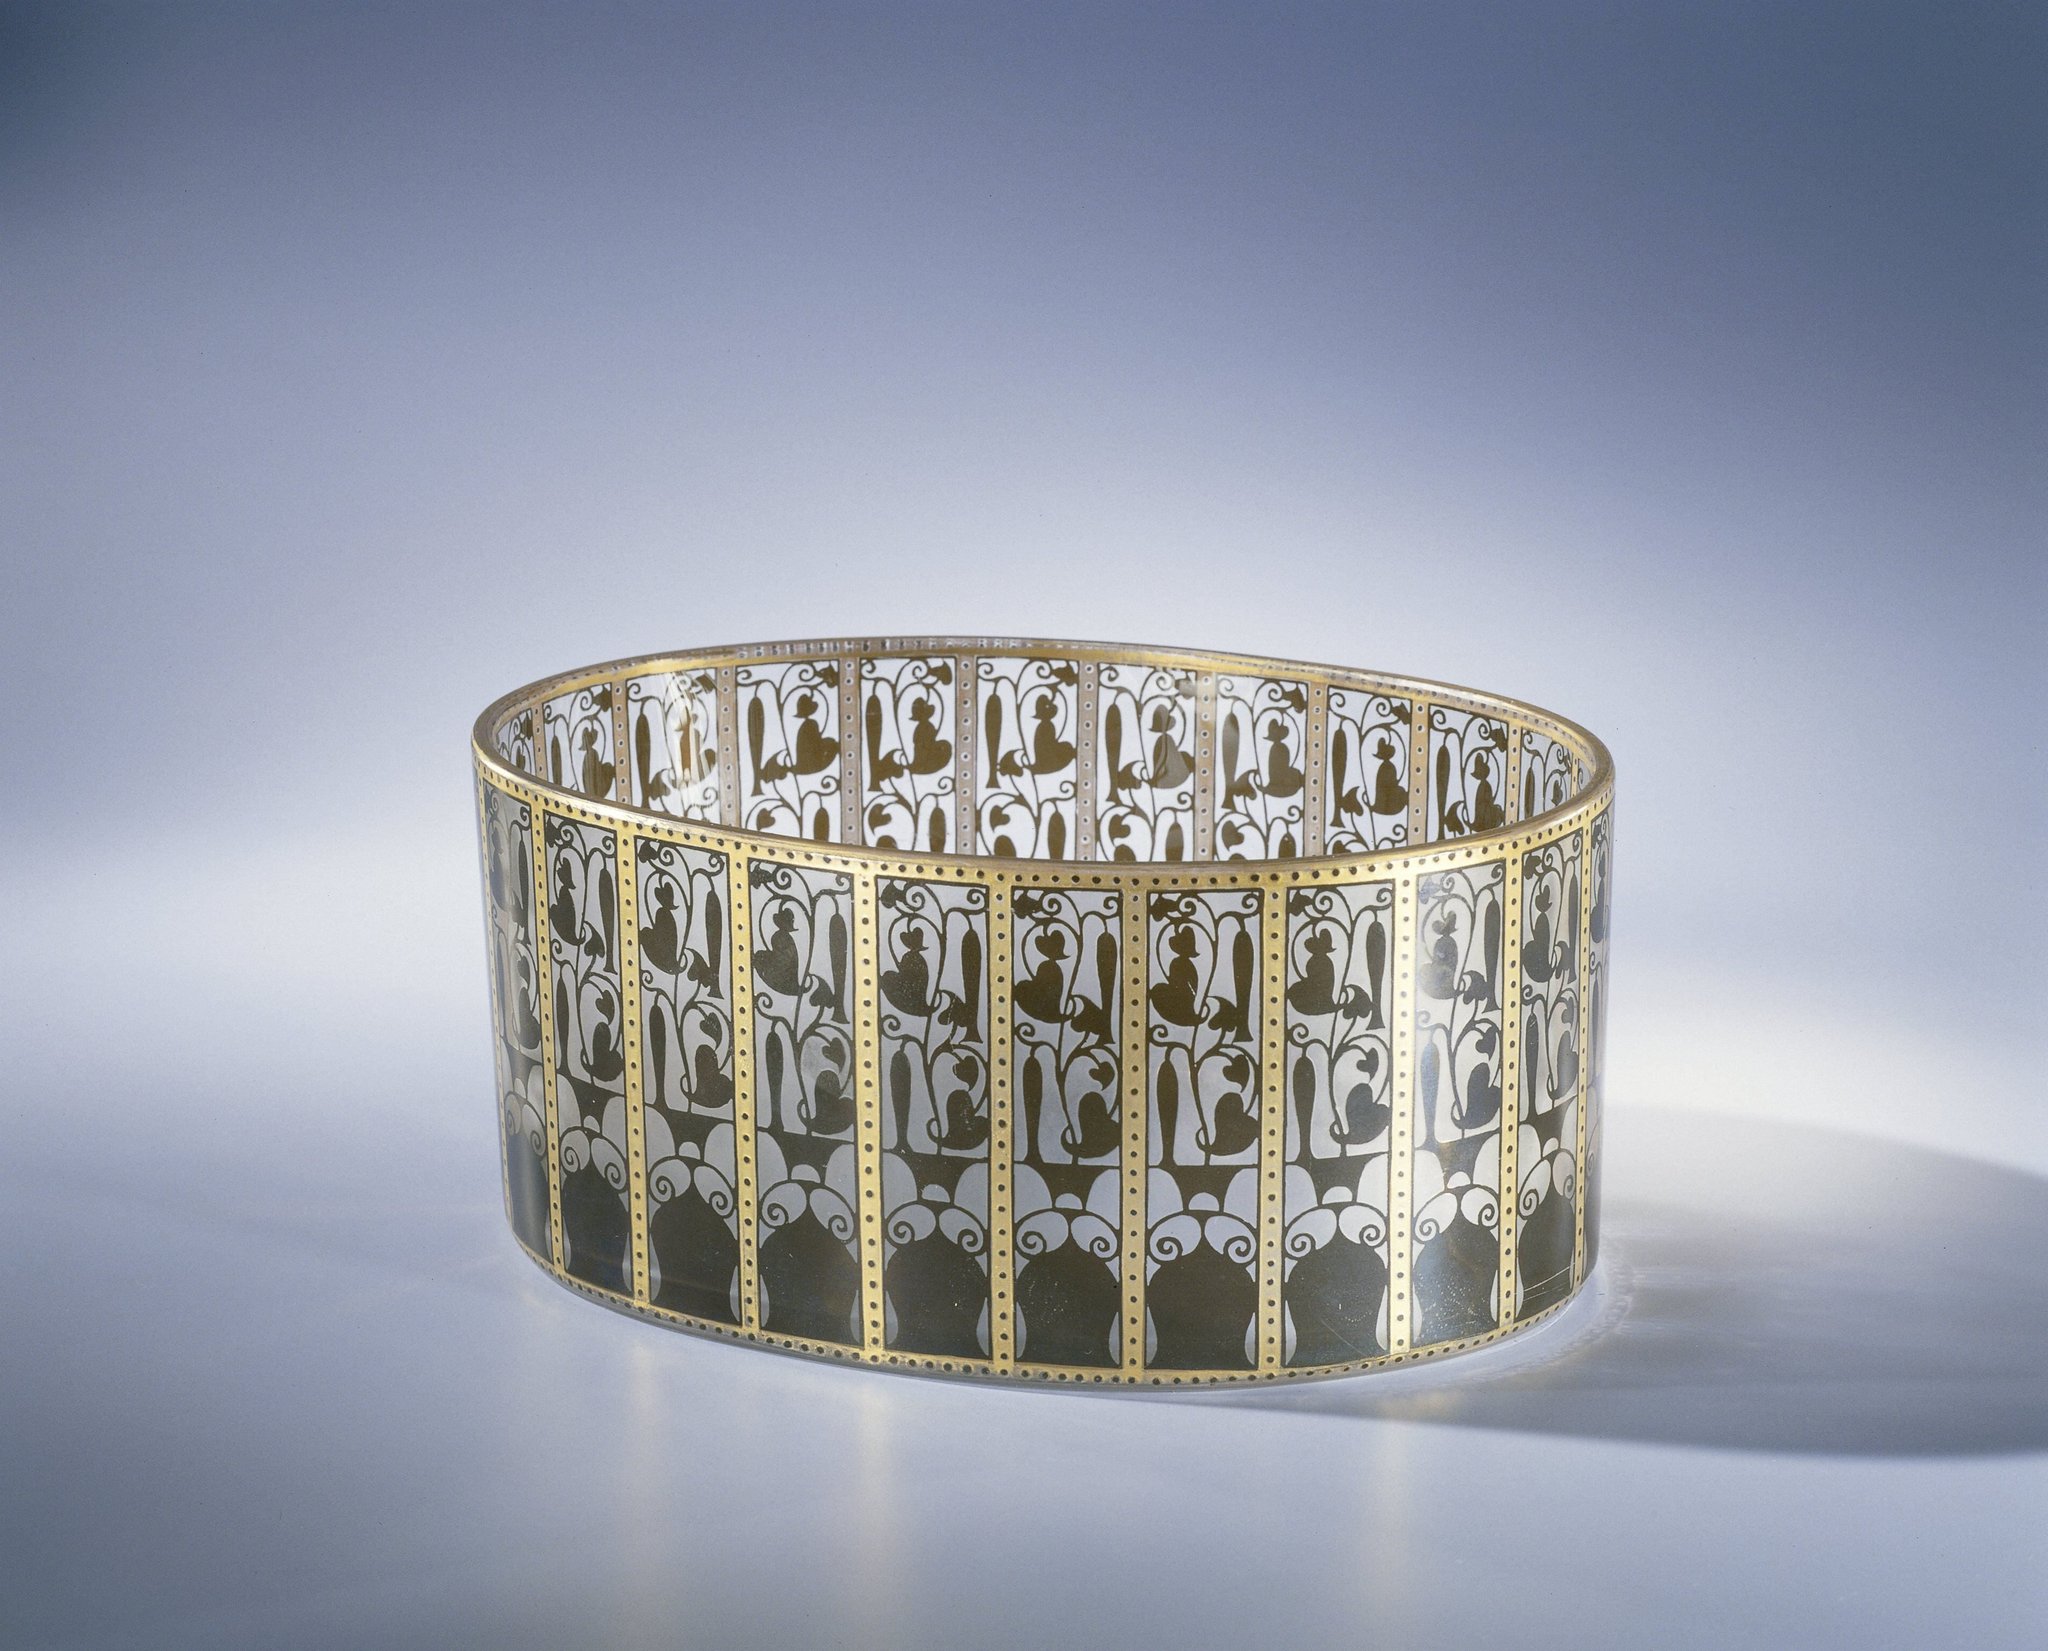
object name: jardinière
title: Jardinière met goud en bronzitdecor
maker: josef hoffmann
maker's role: designer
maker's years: 1870-1956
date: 1910-1911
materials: glass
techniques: etching, gilding, glassblowing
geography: adolf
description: Jardinière. Vienna, J. & L. Lobmeyr, c. 1910 - 1911, designed by Josef Hoffman.